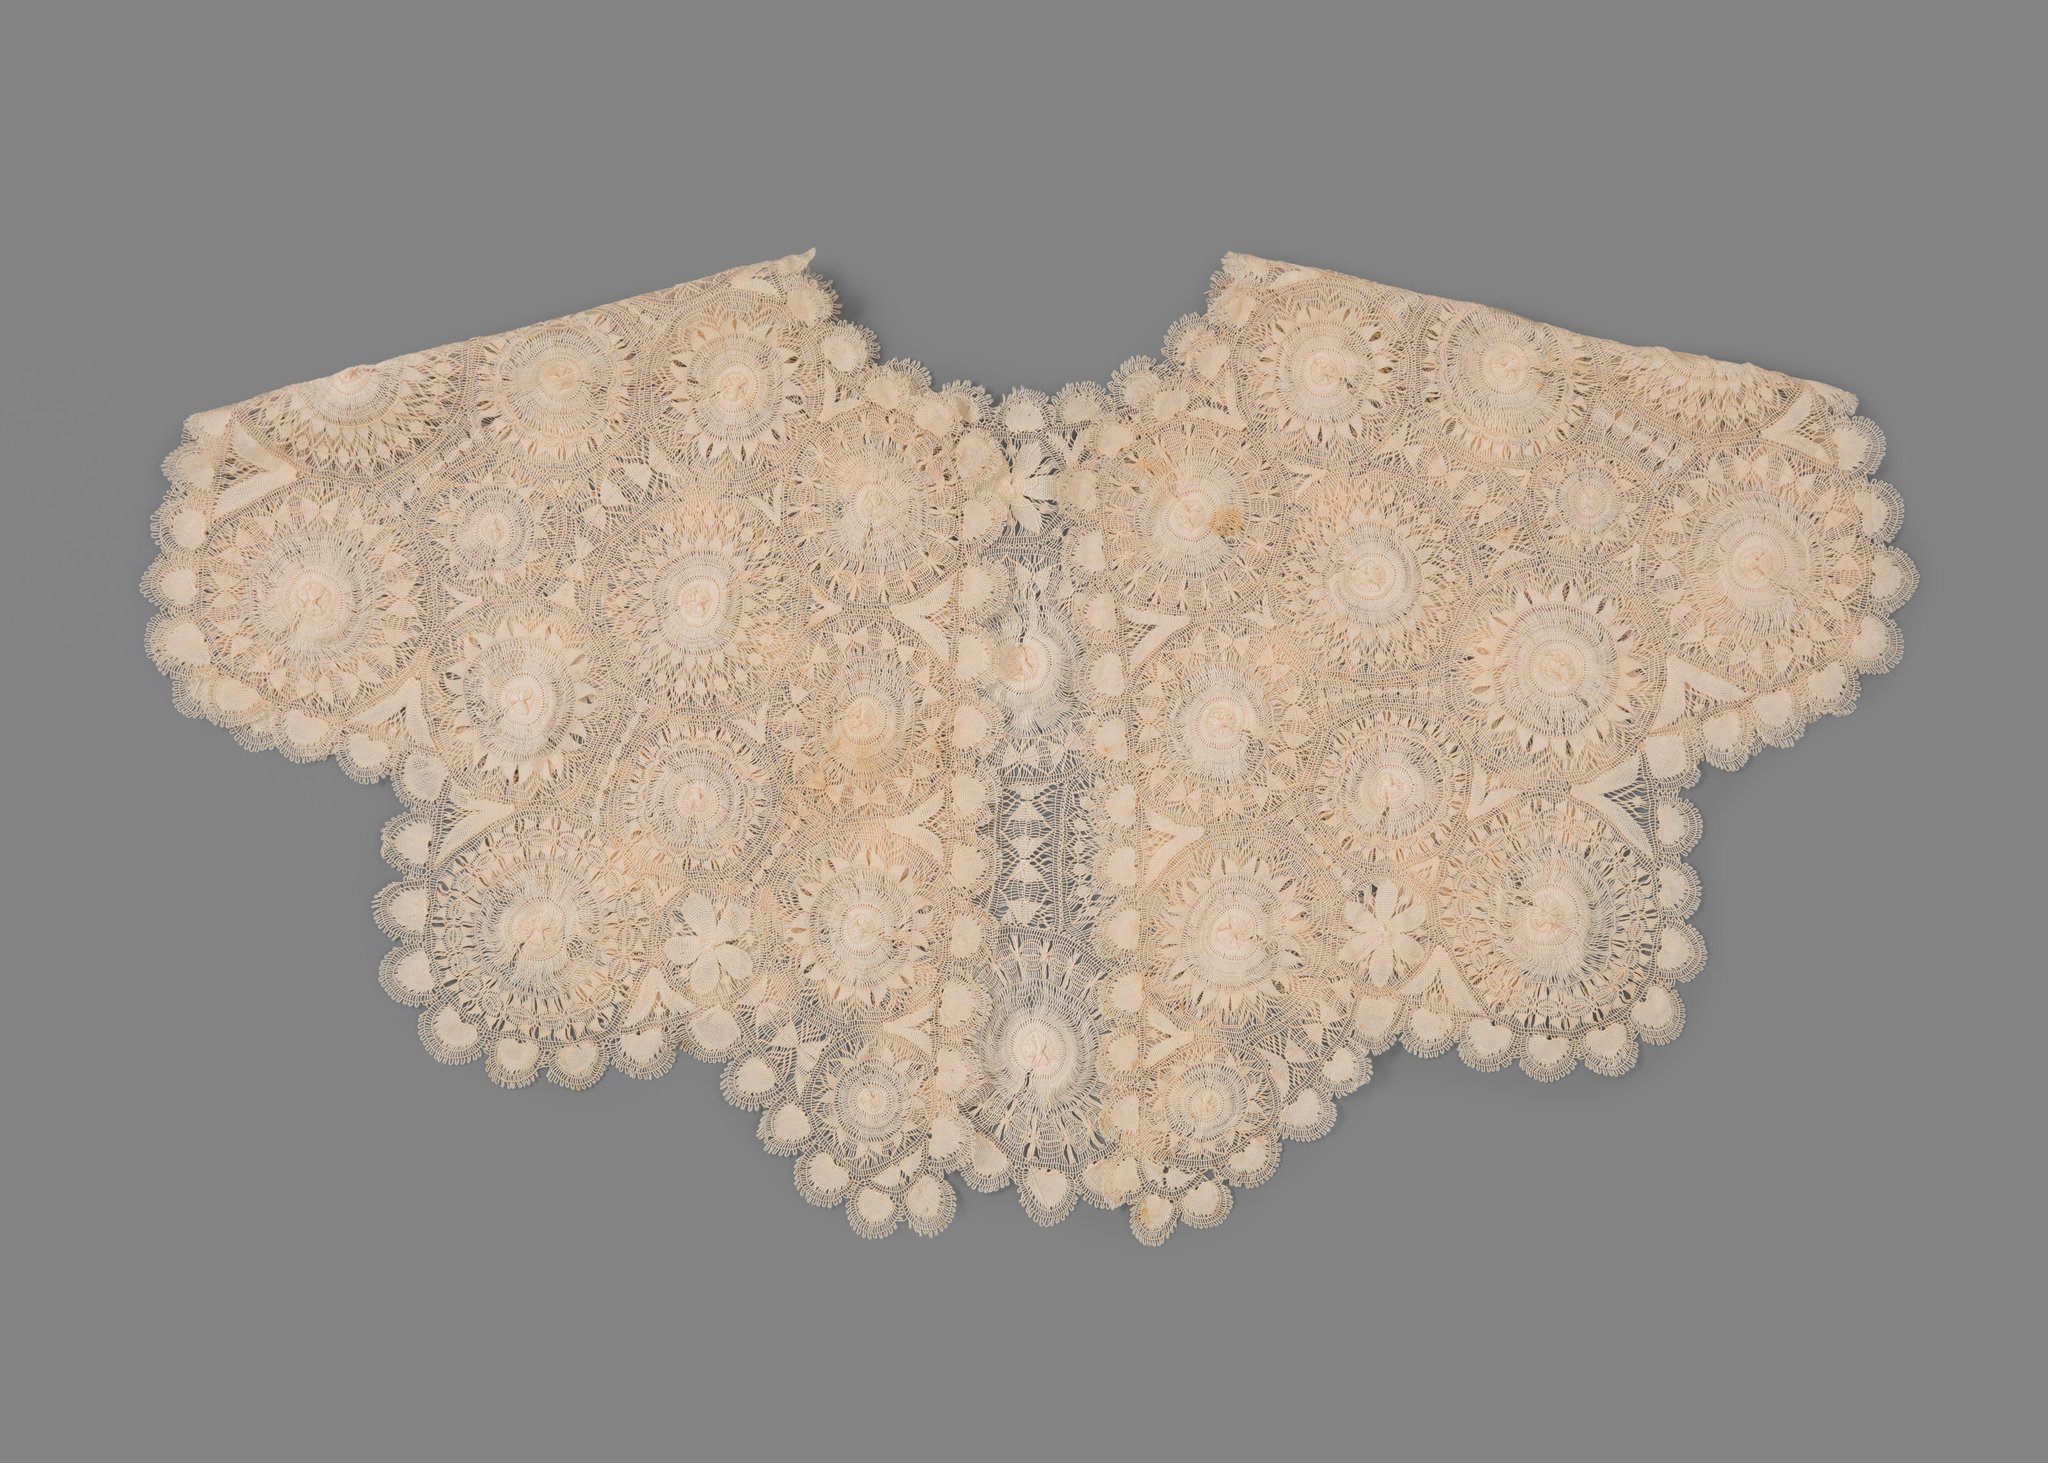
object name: sjaalkraag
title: Sjaalkraag van crèmekleurige zijden naaldkant, Tenerife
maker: Anonymous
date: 1912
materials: silk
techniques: lace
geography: paraguay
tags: de bosch kemper, paraguay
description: Sjaalkraag van crèmekleurige zijde in zogenaamde Tenerife naaldkant. Patroon van grote en kleine cirkels waartussen banden met afwisselend vlinders of cirkels. Langs de rand negen schulpen.